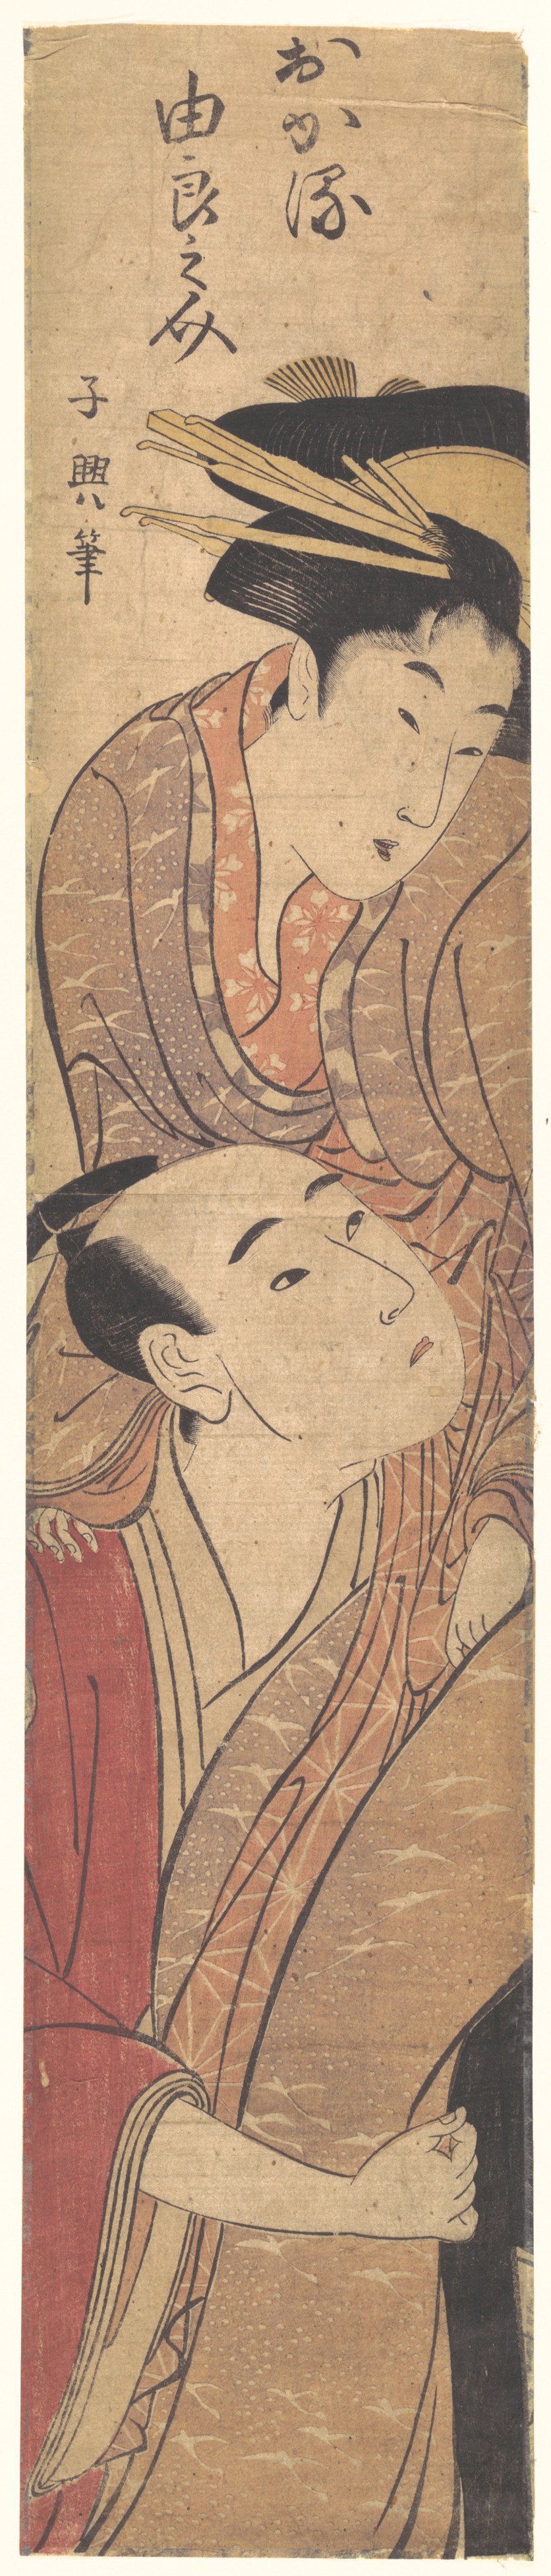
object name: print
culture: japanese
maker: eishōsai chōki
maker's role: artist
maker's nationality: japanese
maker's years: 1700-1900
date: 1771-1835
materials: ink, paper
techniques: woodblock print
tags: men,women